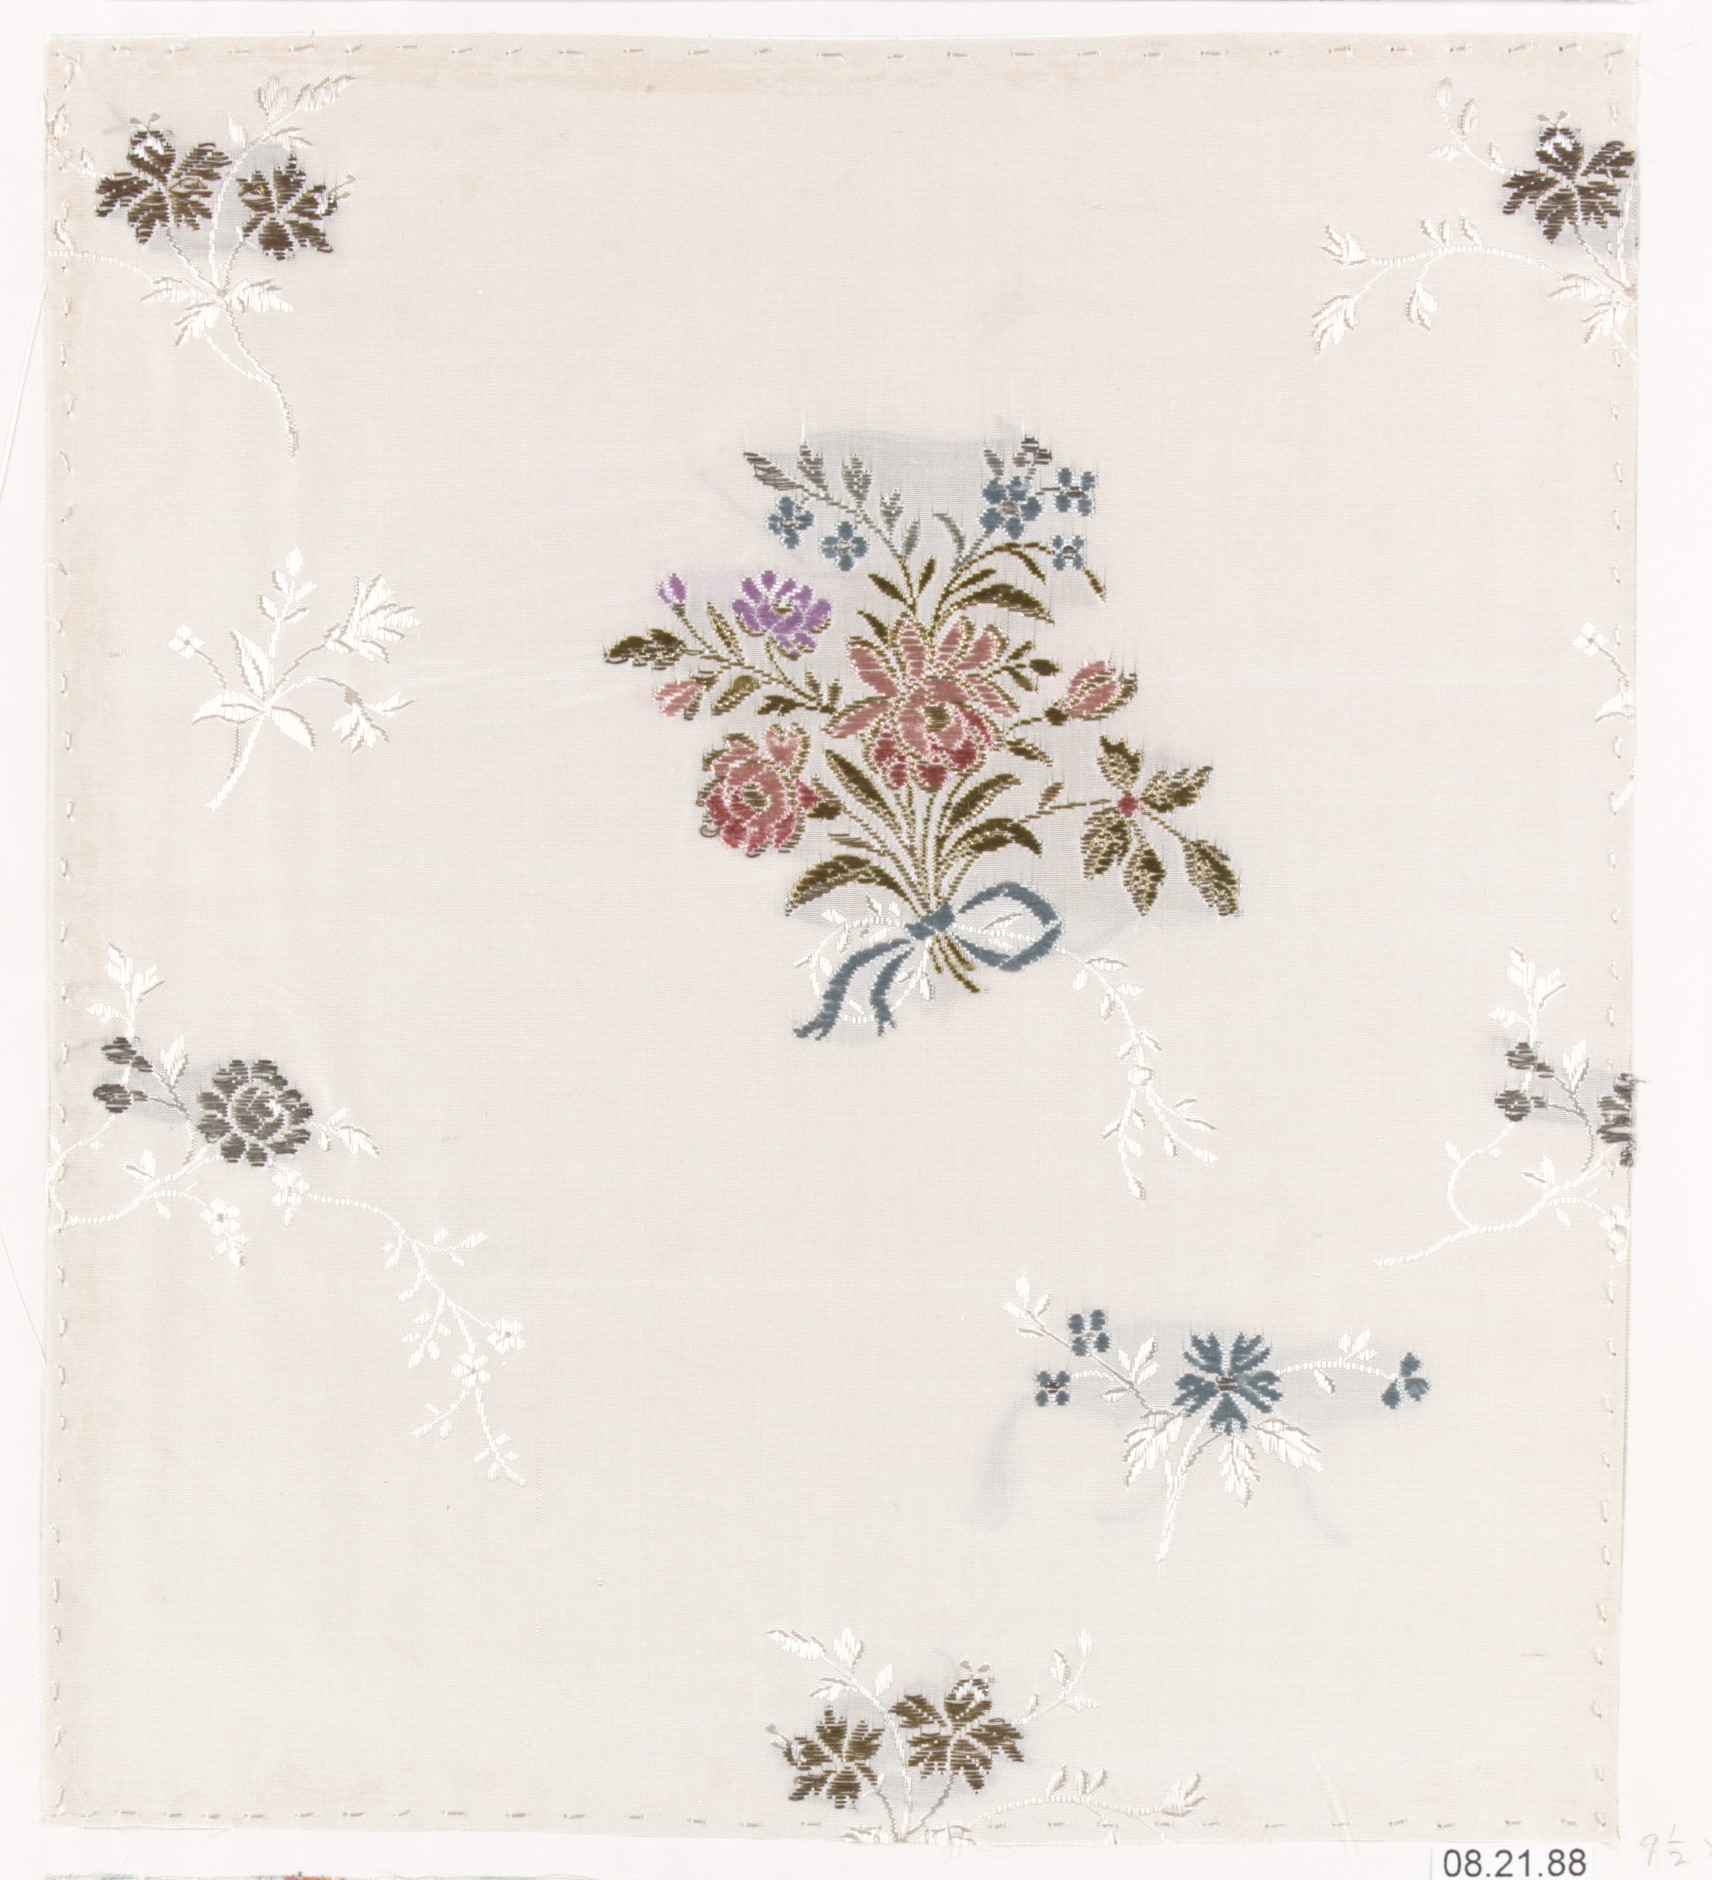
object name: textile sample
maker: Anonymous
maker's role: designer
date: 1900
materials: silk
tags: flowers